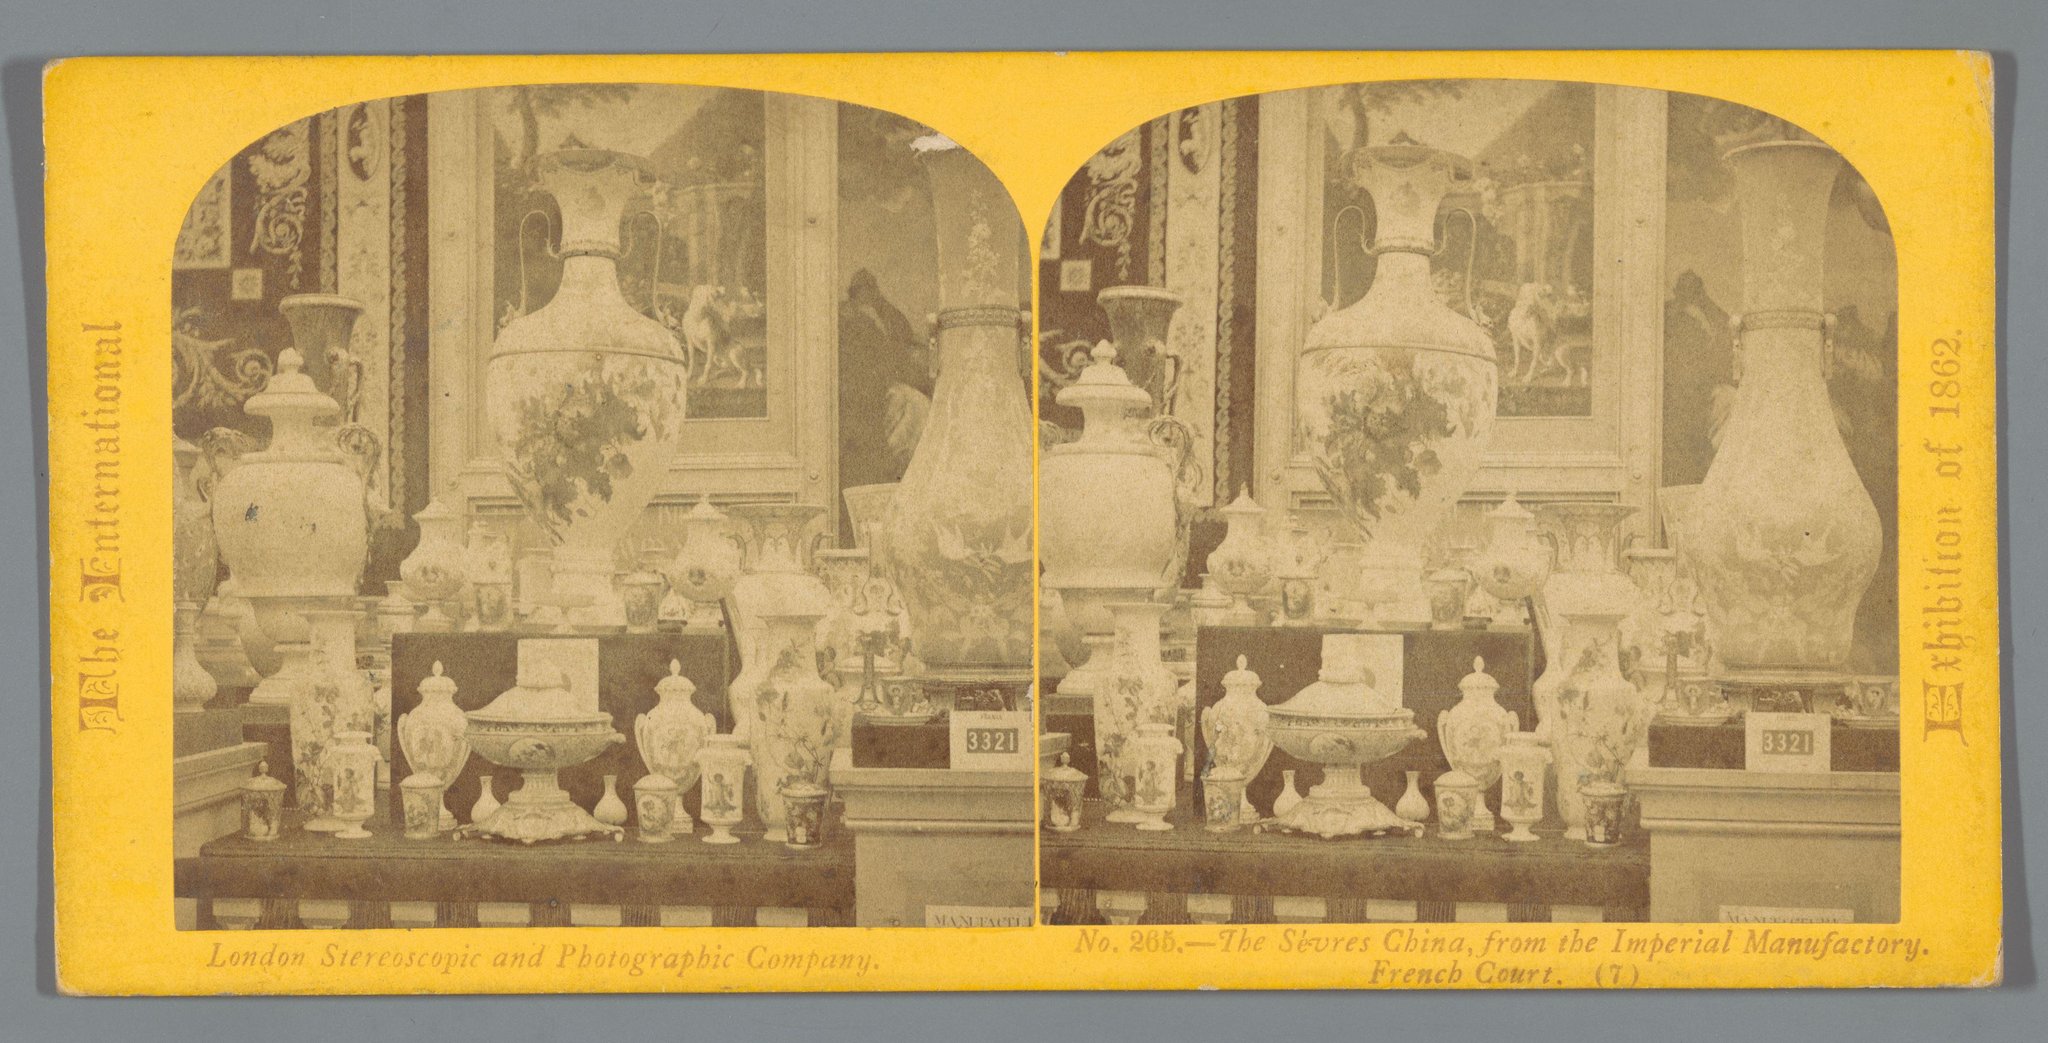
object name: stereograph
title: The International Exhibition of 1862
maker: william england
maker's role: fotograaf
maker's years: 1816-1896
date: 1862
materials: cardboard, paper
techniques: albumen print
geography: london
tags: world fair, world exhibition, container of ceramics: jar, jug, pot, vase, london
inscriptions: number: ‘No. 265.’